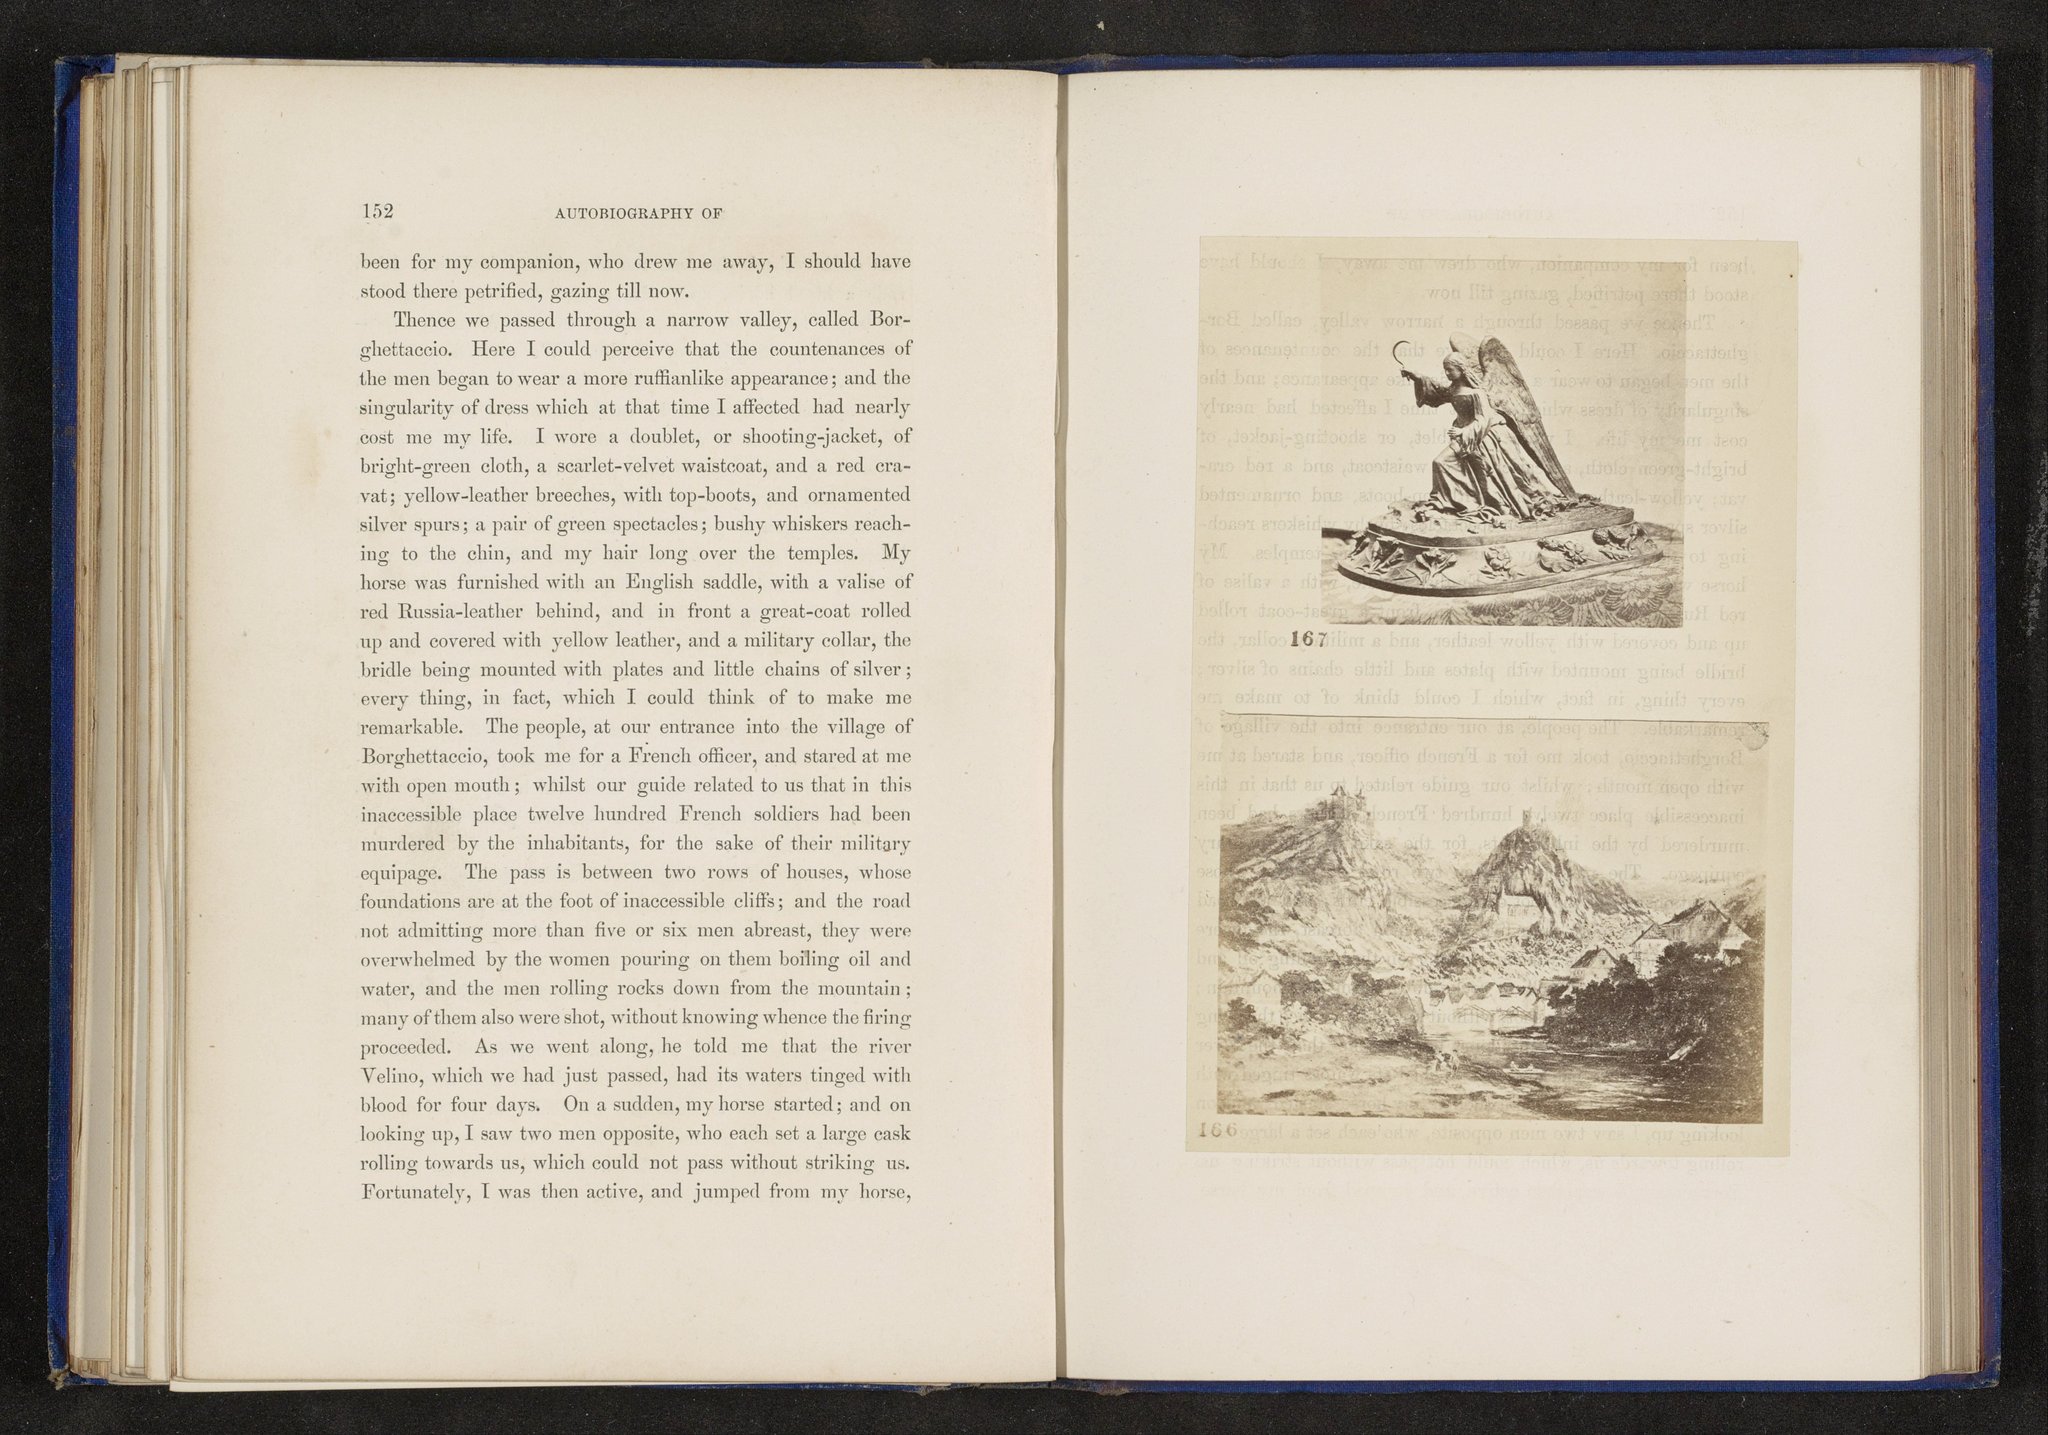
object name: page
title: Zonnewijzer in de vorm van een engel en een schilderij met een gezicht op Idar-Oberstein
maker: f. cole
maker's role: fotograaf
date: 1857-1867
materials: photographic support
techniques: albumen print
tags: city-view in general; 'veduta', sundial, angels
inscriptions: number: ‘166, 167’